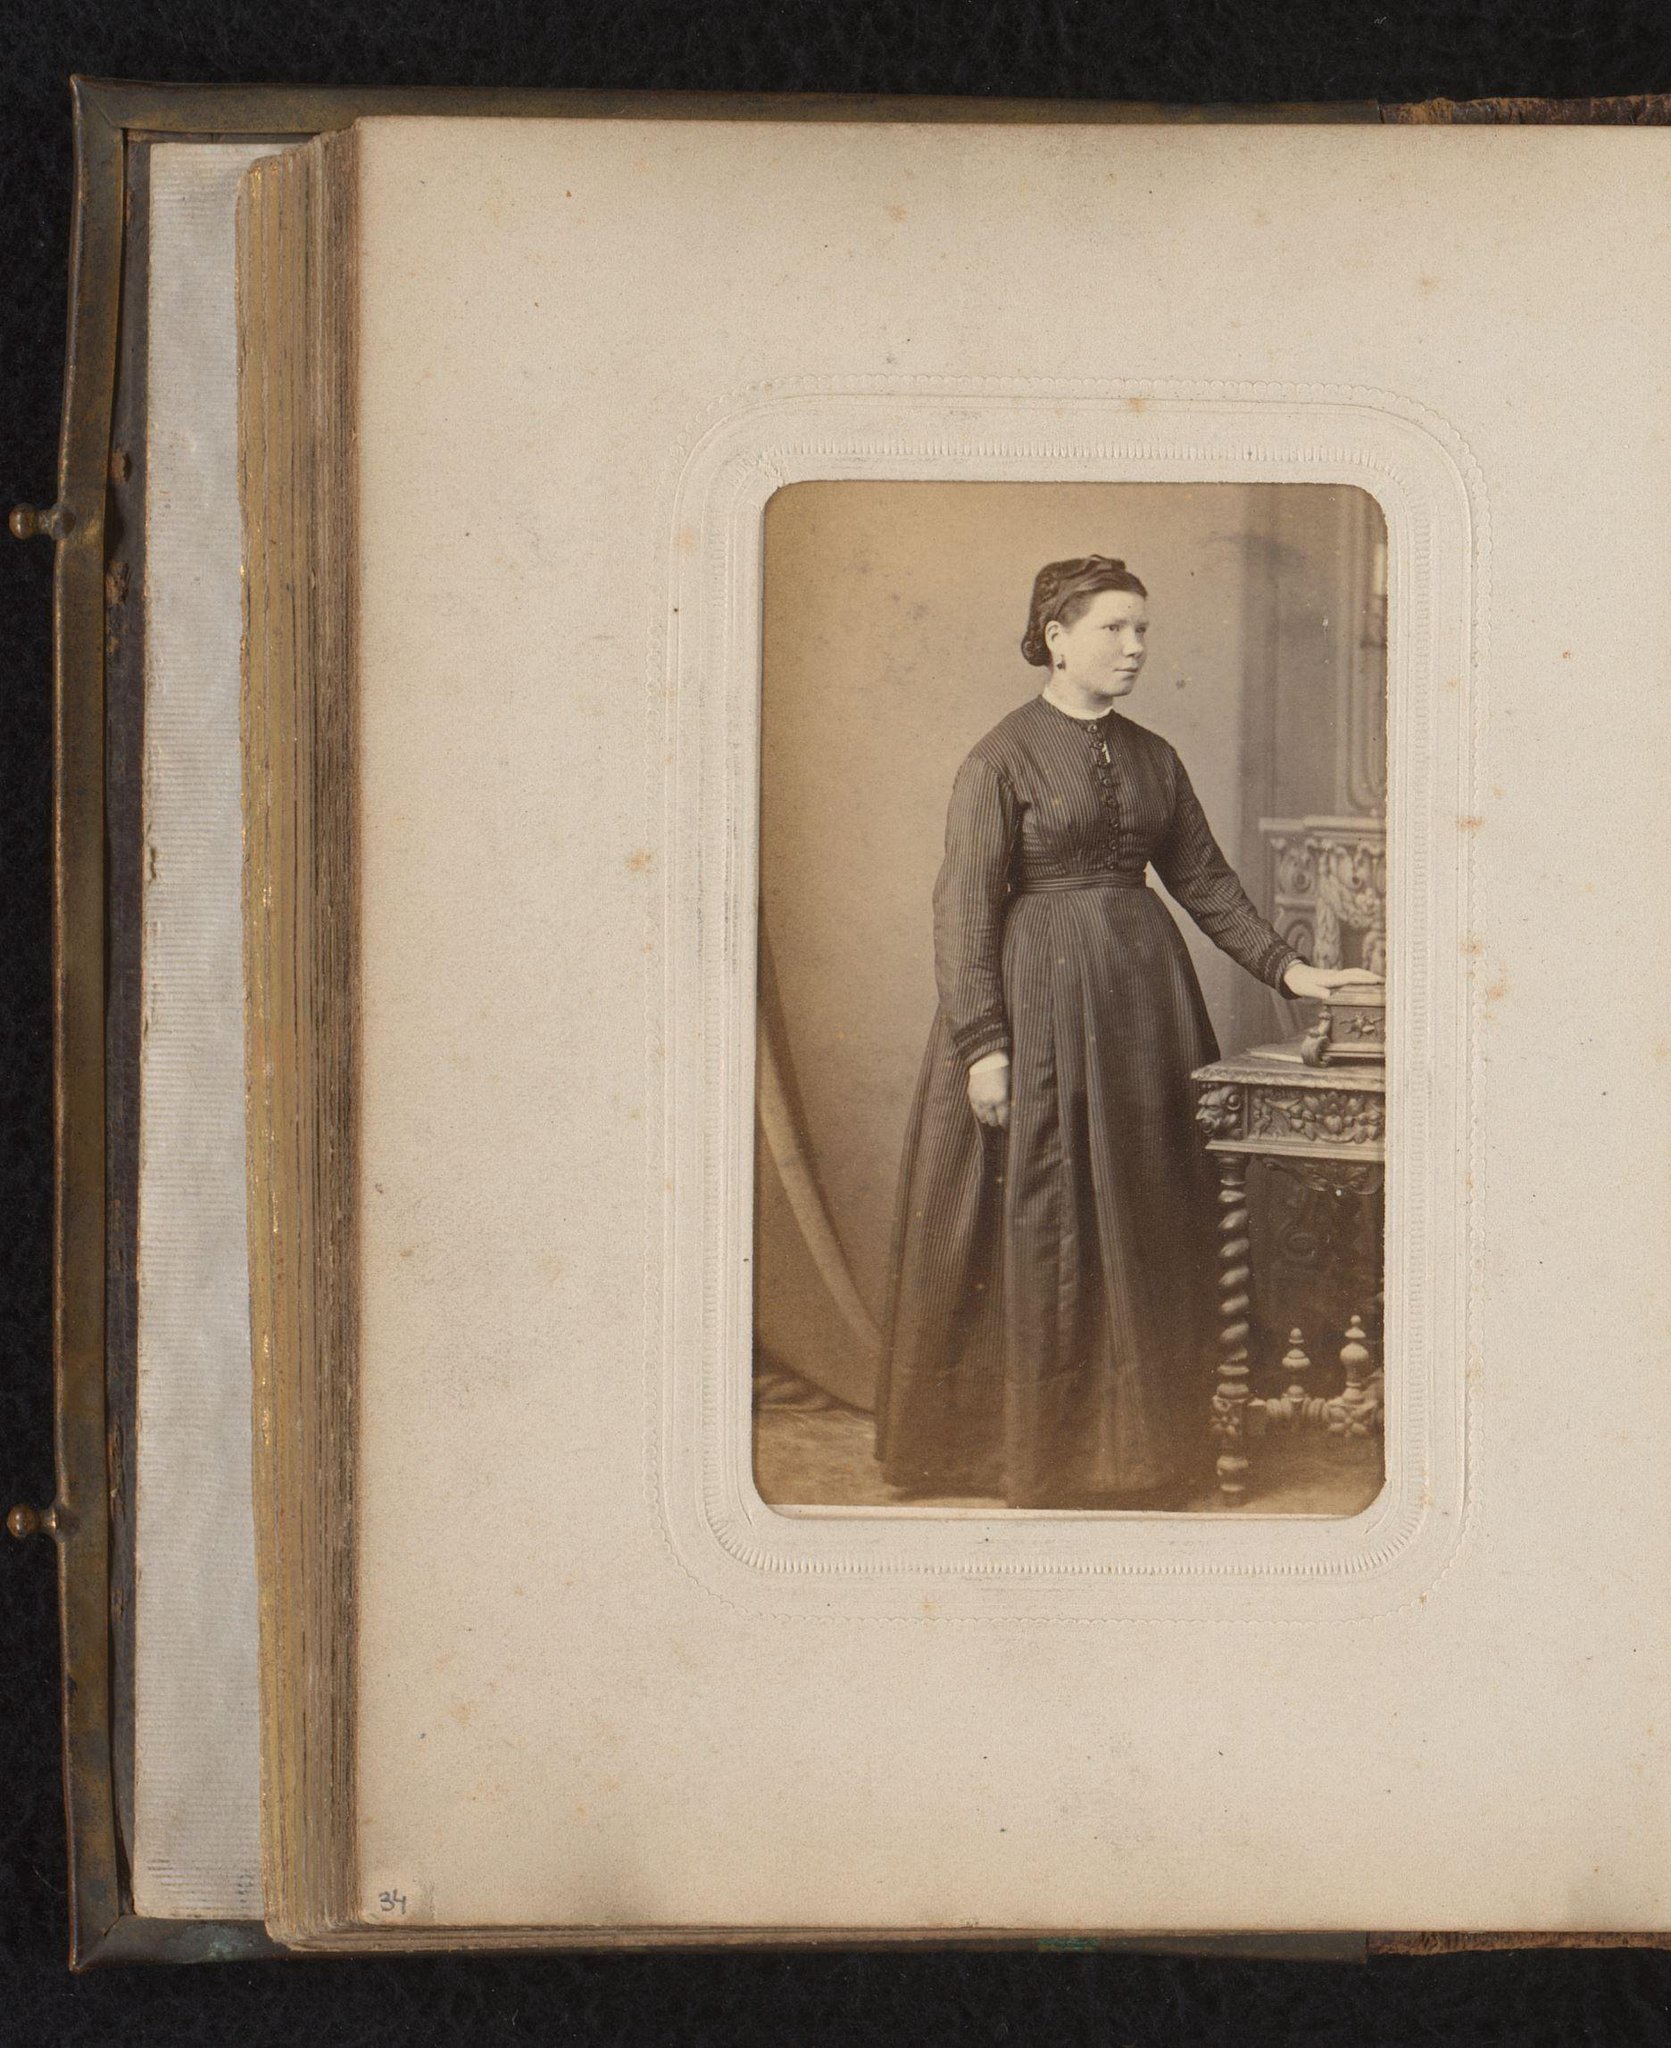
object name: carte de visite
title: Portret van een staande vrouw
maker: jules alexandre joseph delzor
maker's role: fotograaf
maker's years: 1841-1902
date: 1860-1900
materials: cardboard, photographic support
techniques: albumen print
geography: verdun-sur-meuse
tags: historical persons - bb - woman, standing figure - aa - female human figure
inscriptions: inscription: ‘PHOTOGRAPHIE/ J. DELZOR/ Place de la Gendarmerie No 6/ VERDUN.’